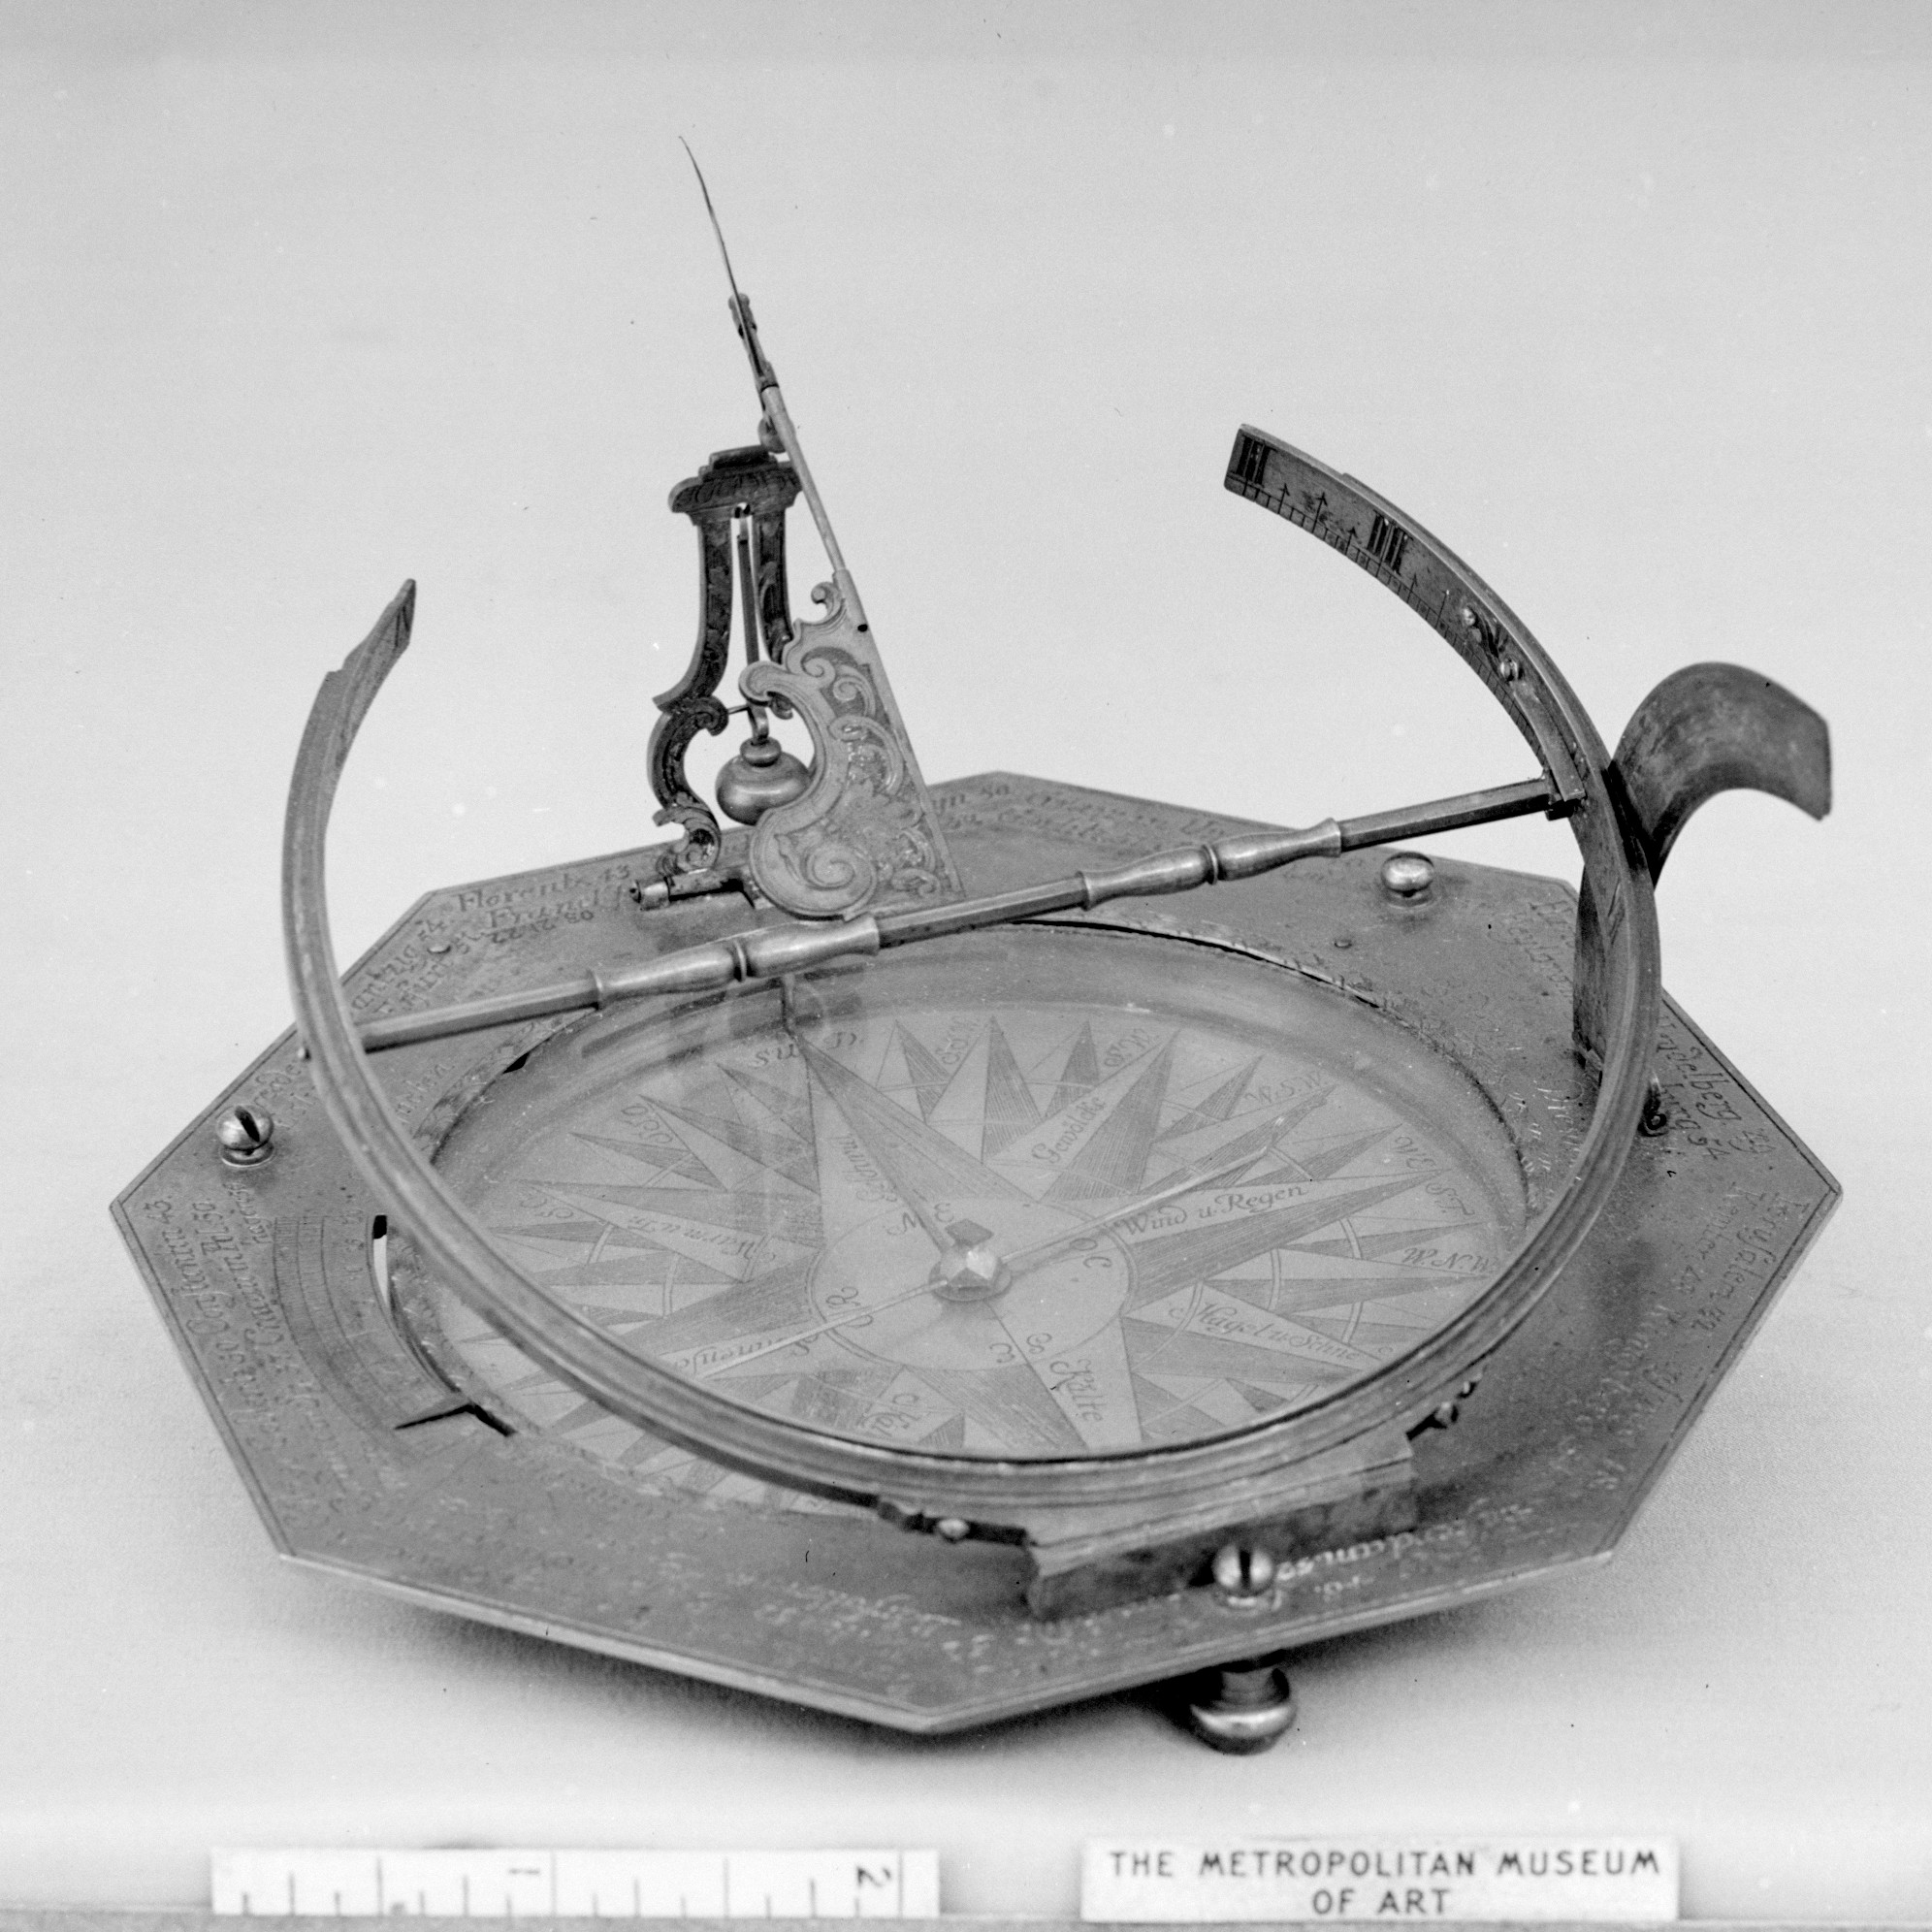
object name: portable equatorial sundial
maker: ludewig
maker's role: maker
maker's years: 1675-1775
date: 1725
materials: brass, silver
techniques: gilding, silvered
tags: sundials